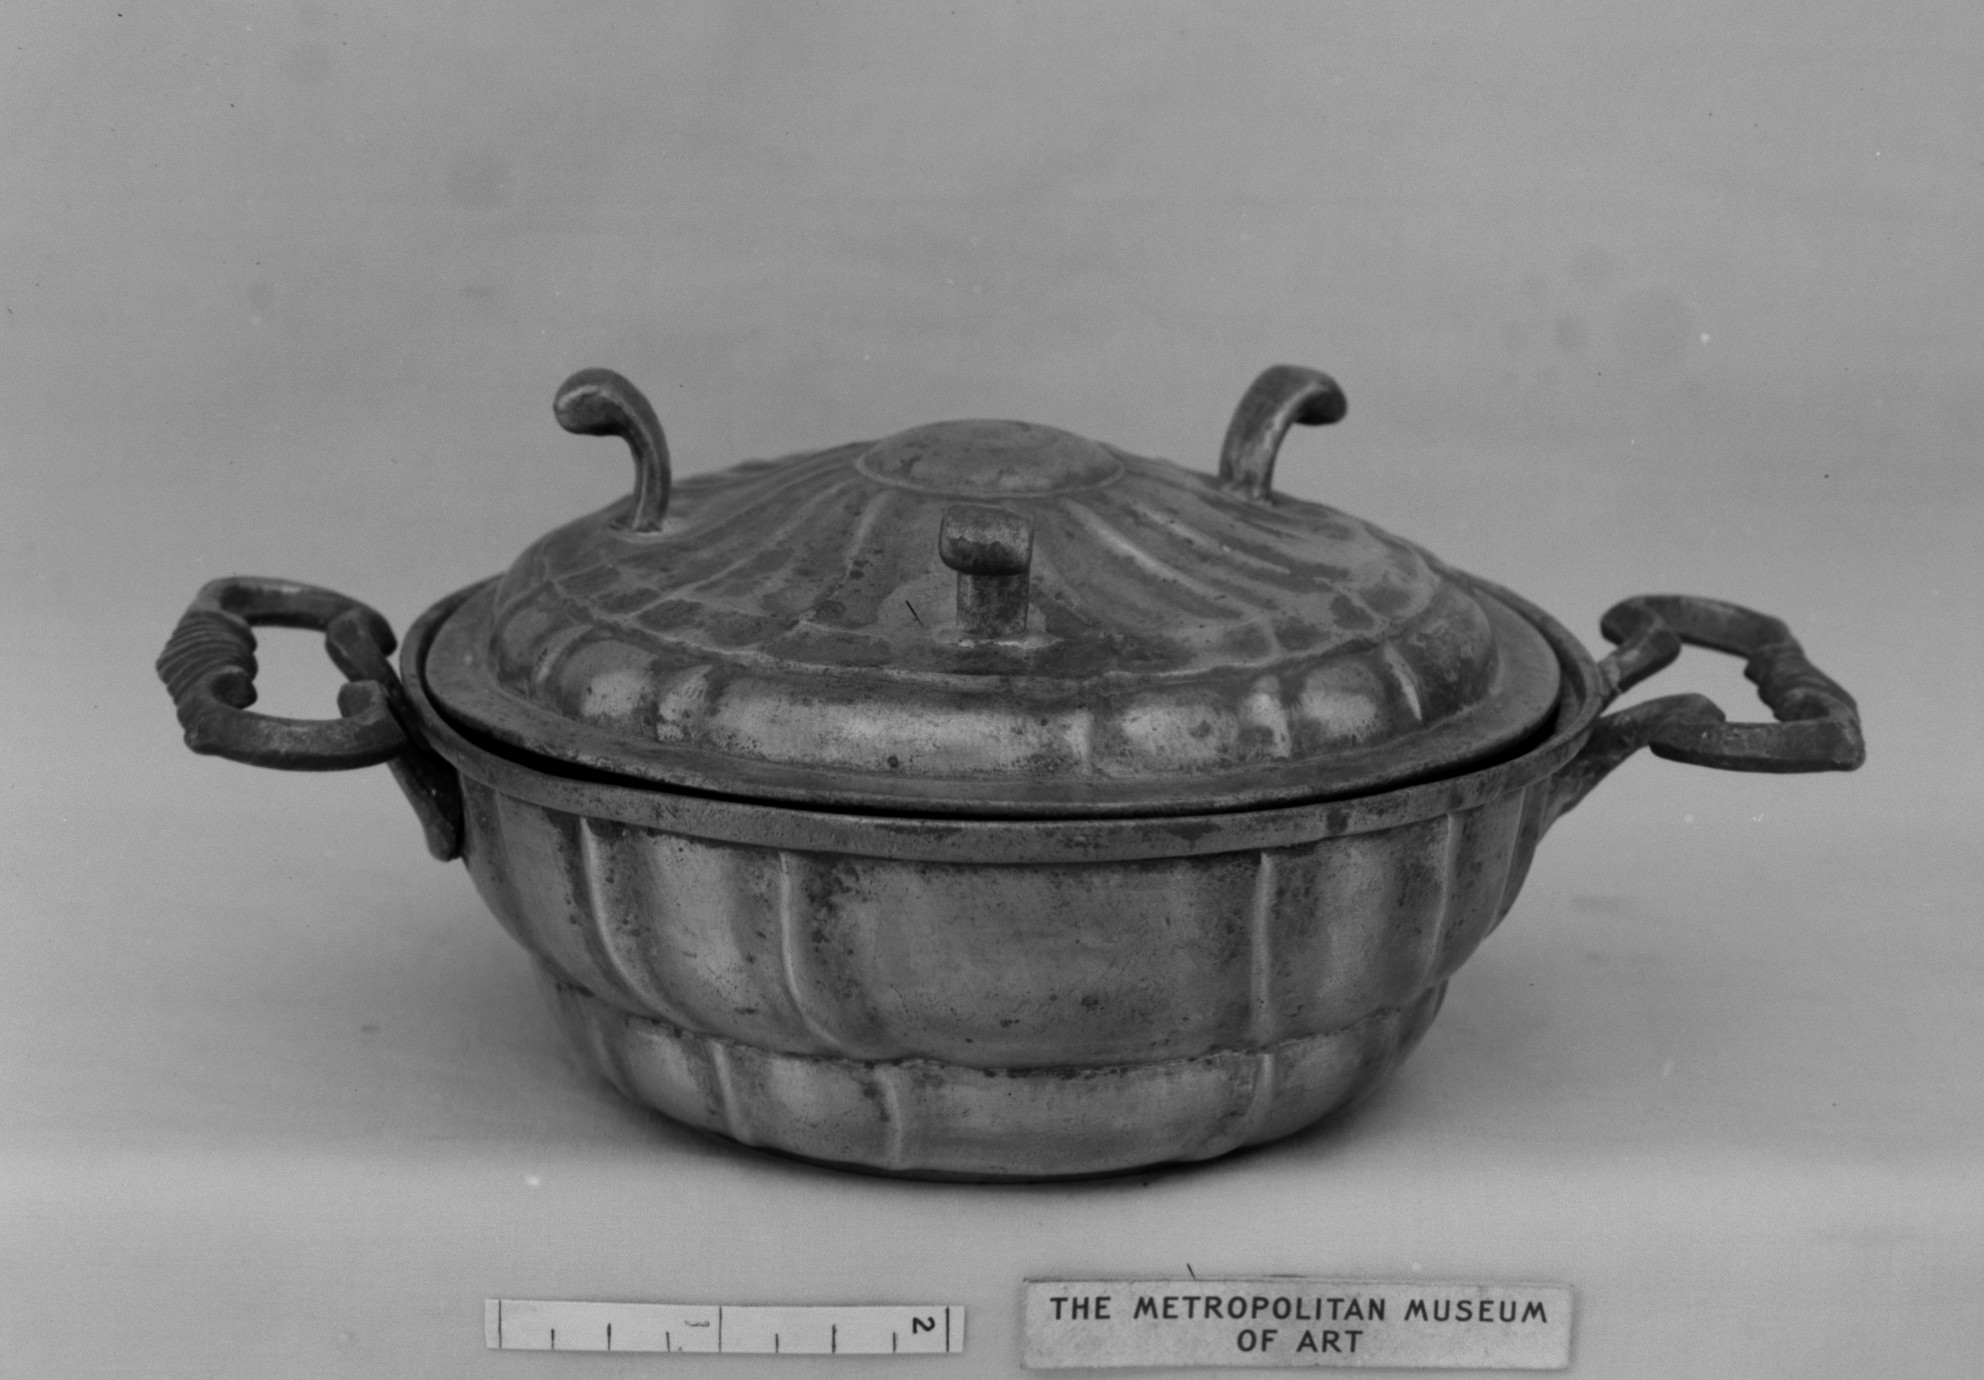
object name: porringer with cover or posset cup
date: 1701-1800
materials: pewter